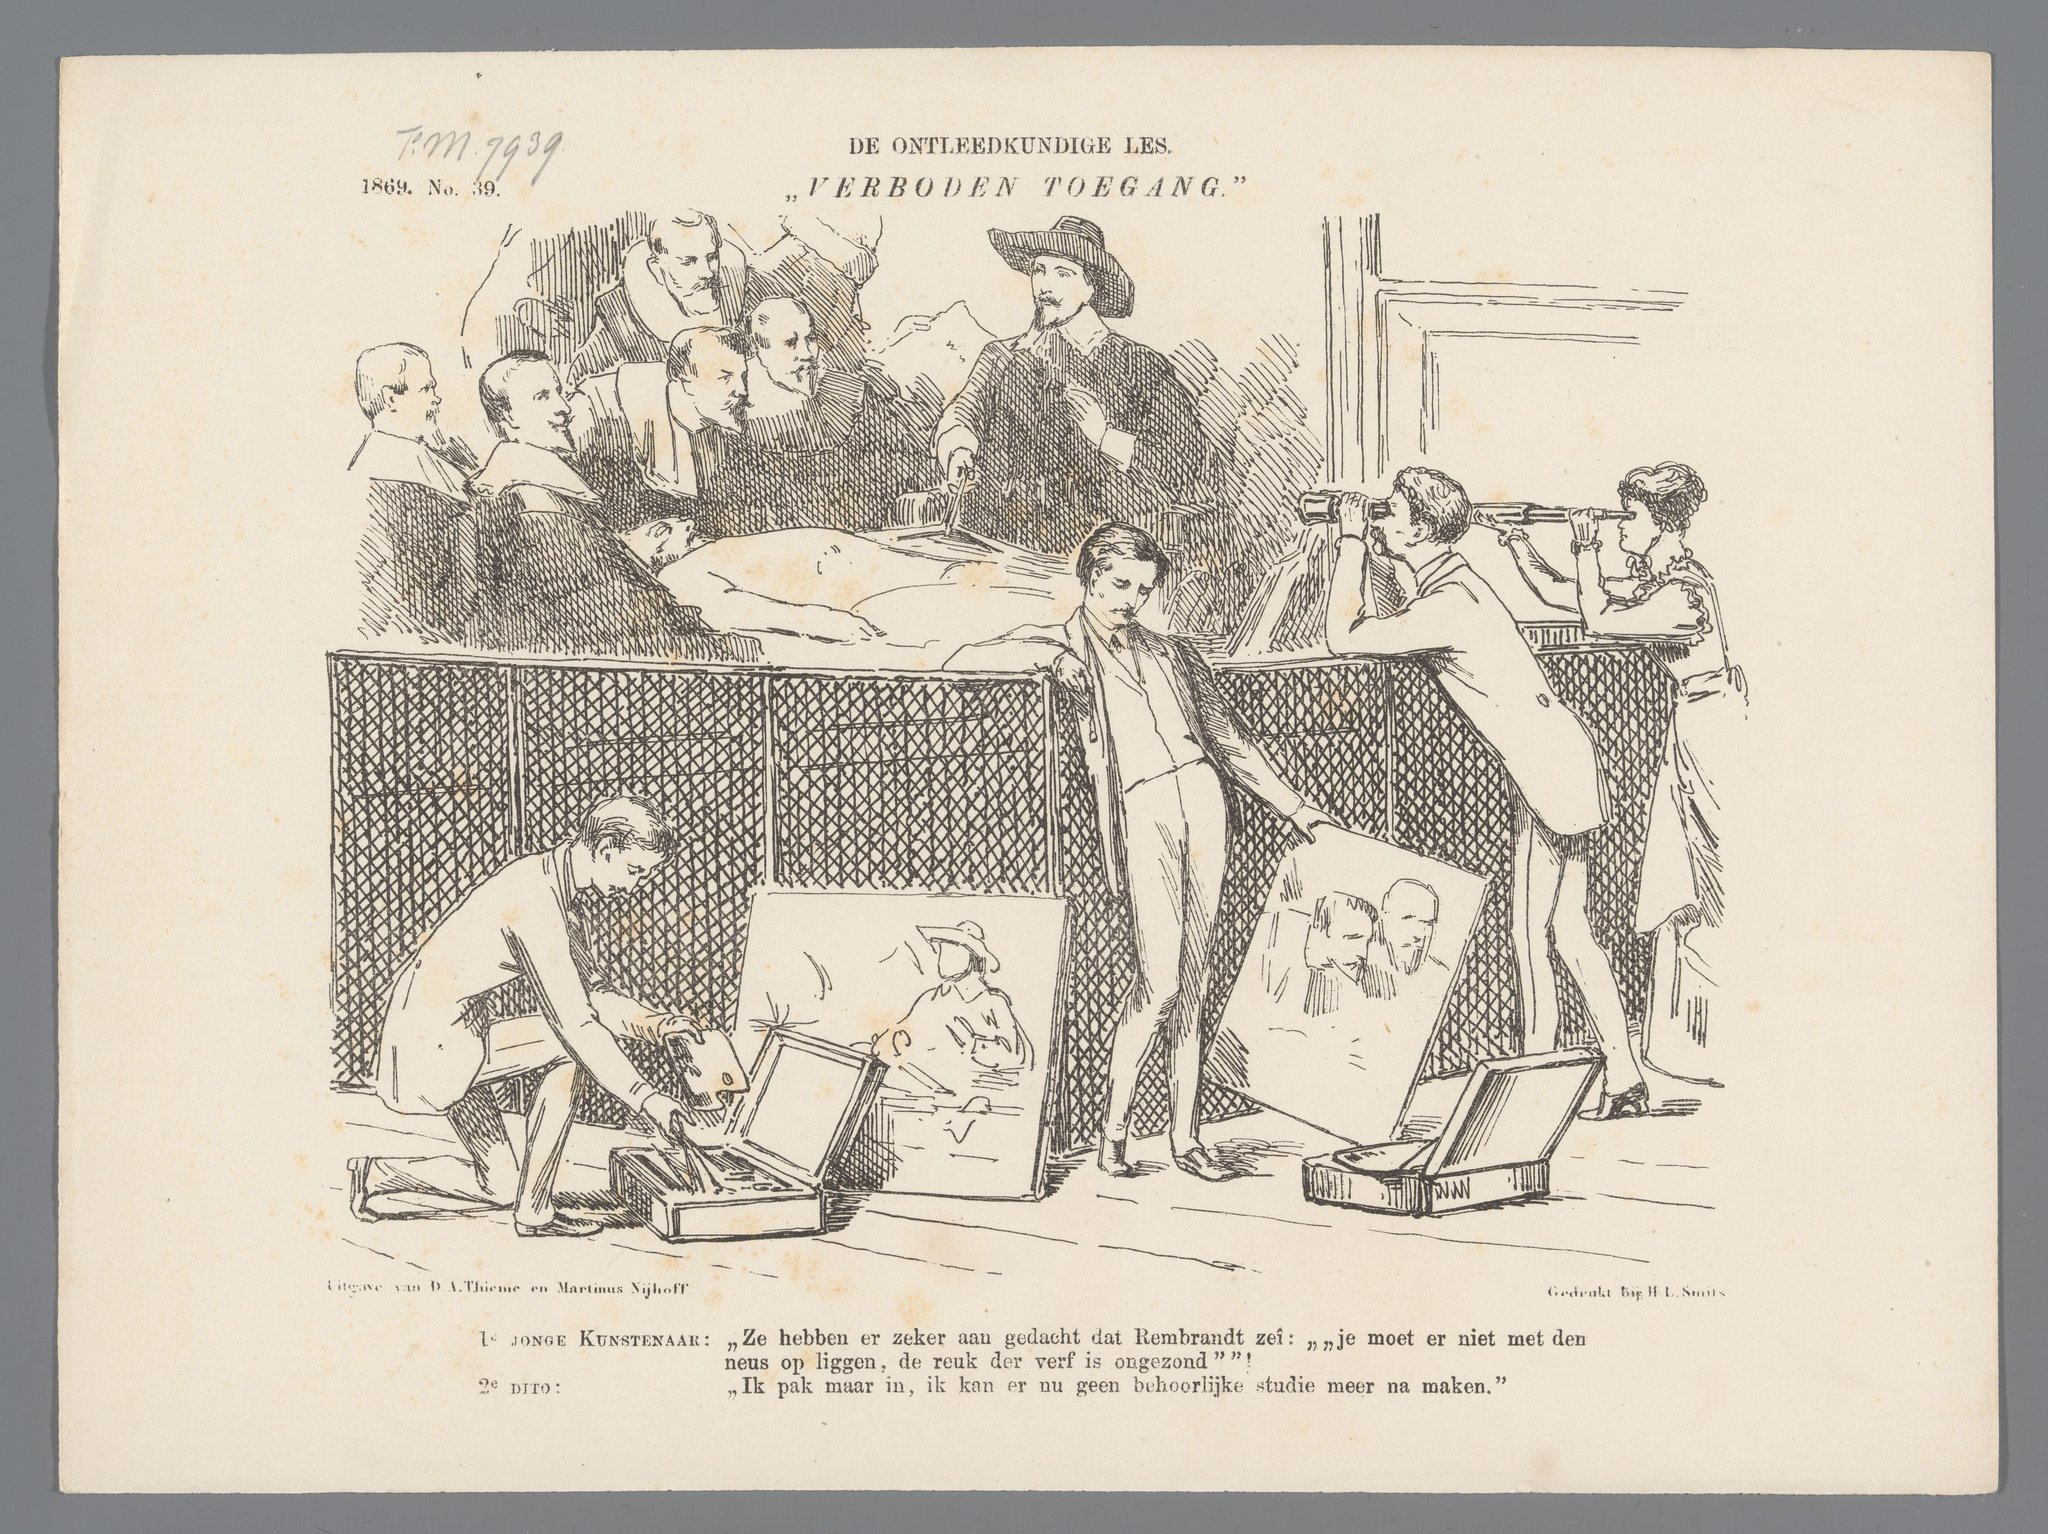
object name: cartoon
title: Spotprent op de omheining om Rembrandts anatomische les van Dr. Nicolaes Tulp, 1869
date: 1869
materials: paper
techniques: lithograph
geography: the hague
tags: leiden, amsterdam, painter, print maker, draughtsman, rembrandt van rijn, mayor, permanent exhibition, museum, picture, painting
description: Spotprent op het plaatsen van een omheining om Rembrandts schilderij van de Anatomische les van Dr. Nicolaes Tulp, waardoor tekenaars er niet meer dichtbij kunnen komen en daarom hun spullen inpakken en vertrekken. Plaat verschenen bij het weekblad De Nederlandsche Spectator, nr. 39, 1869.